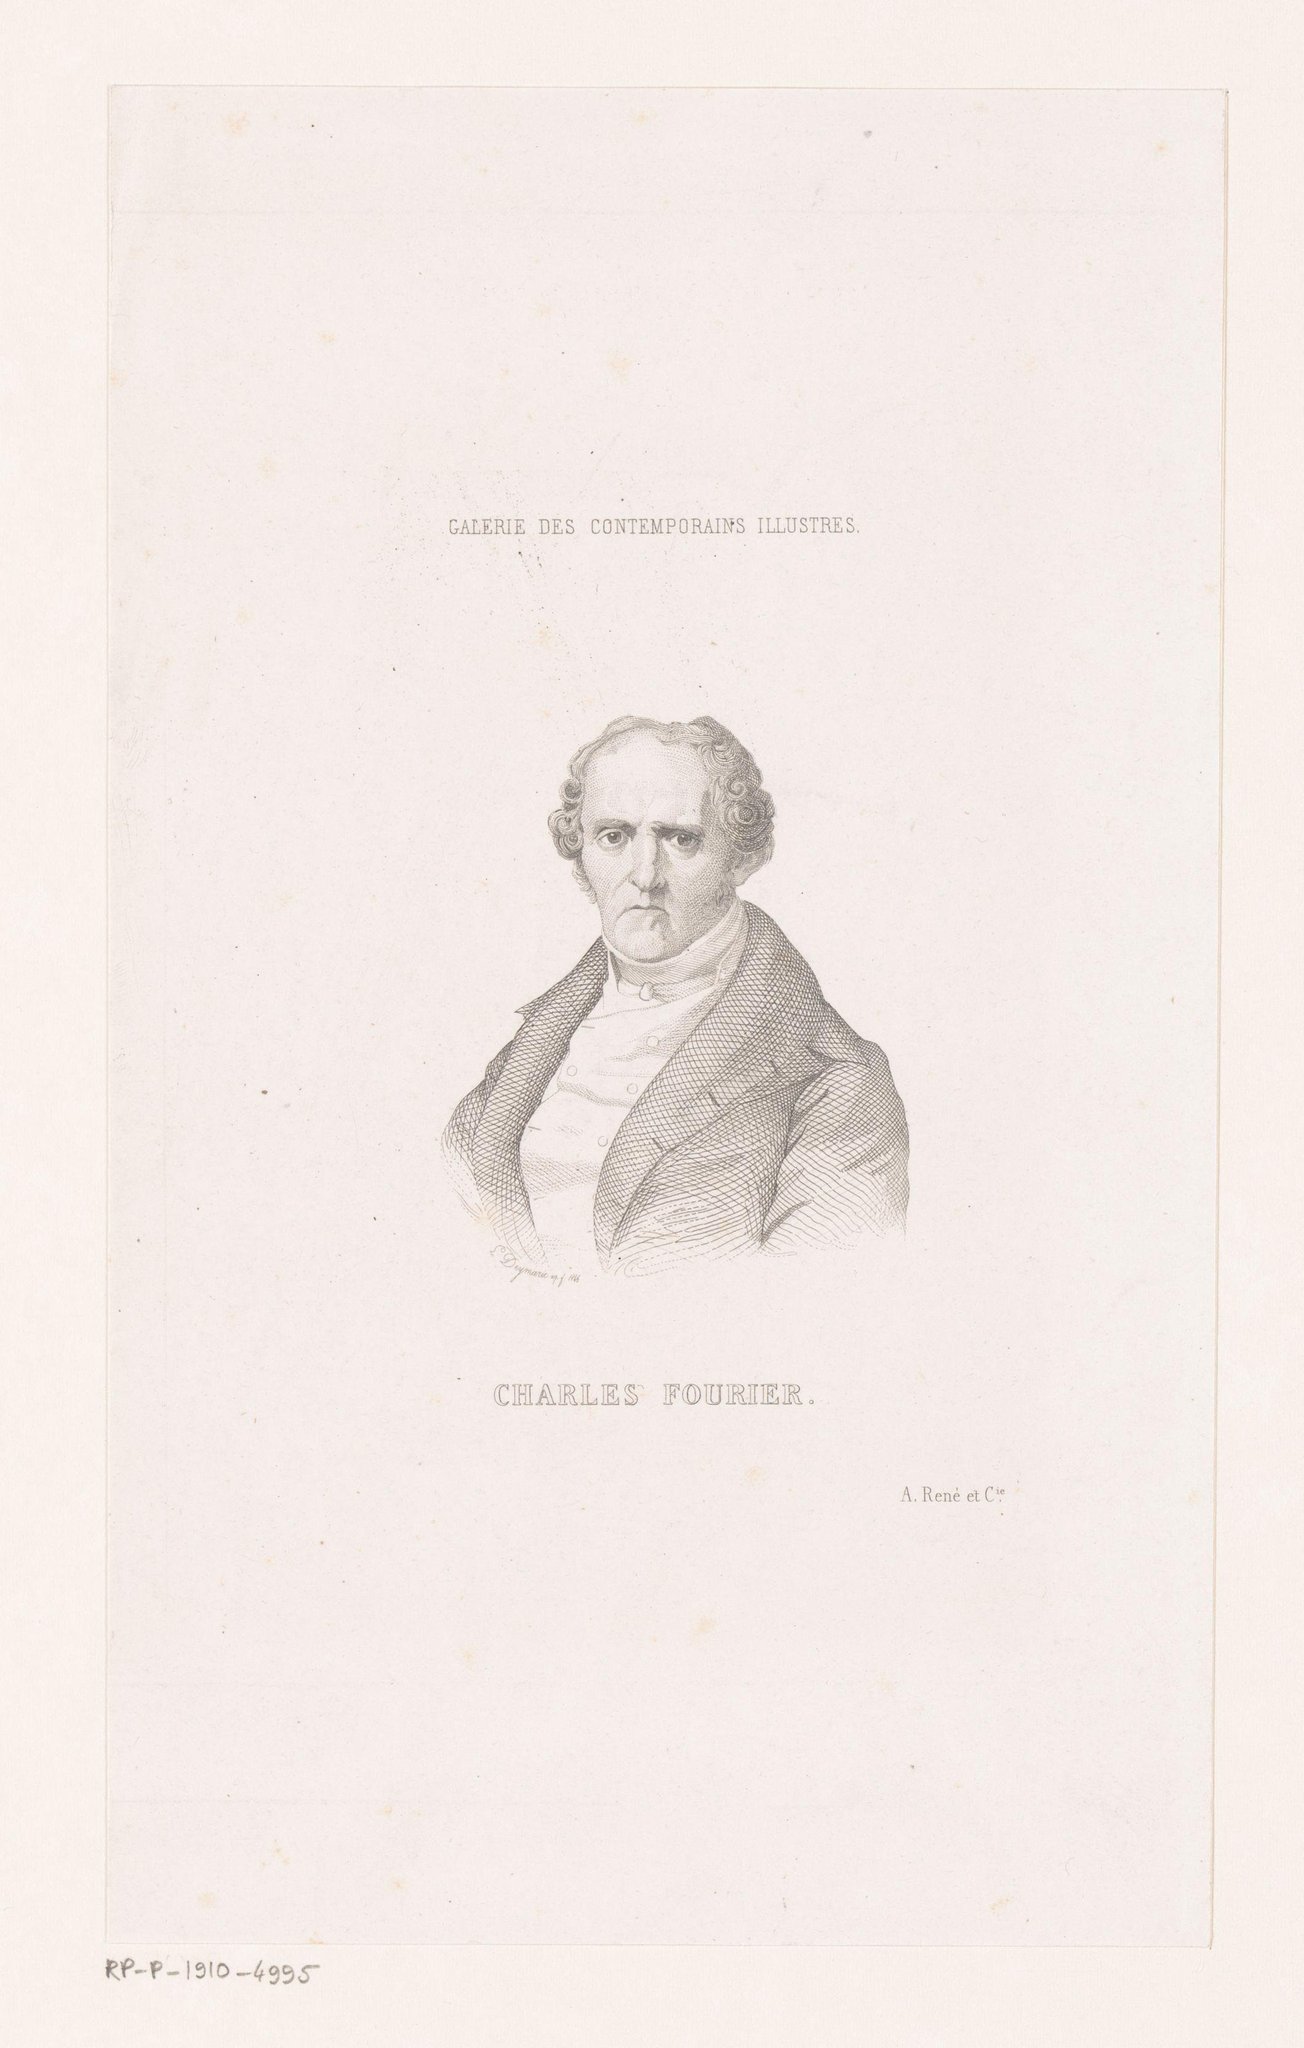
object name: book illustration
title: Portret van Charles Fourier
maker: l. deymarie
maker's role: print maker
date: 1846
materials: paper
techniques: etching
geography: paris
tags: paris, scholar, philosopher, historical persons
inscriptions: collector's mark: Lugt 2228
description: Prent uit: Loménie, Louis de. Galerie des contemporains illustres / par un homme de rien. Parijs: René, A. 1840-1847.